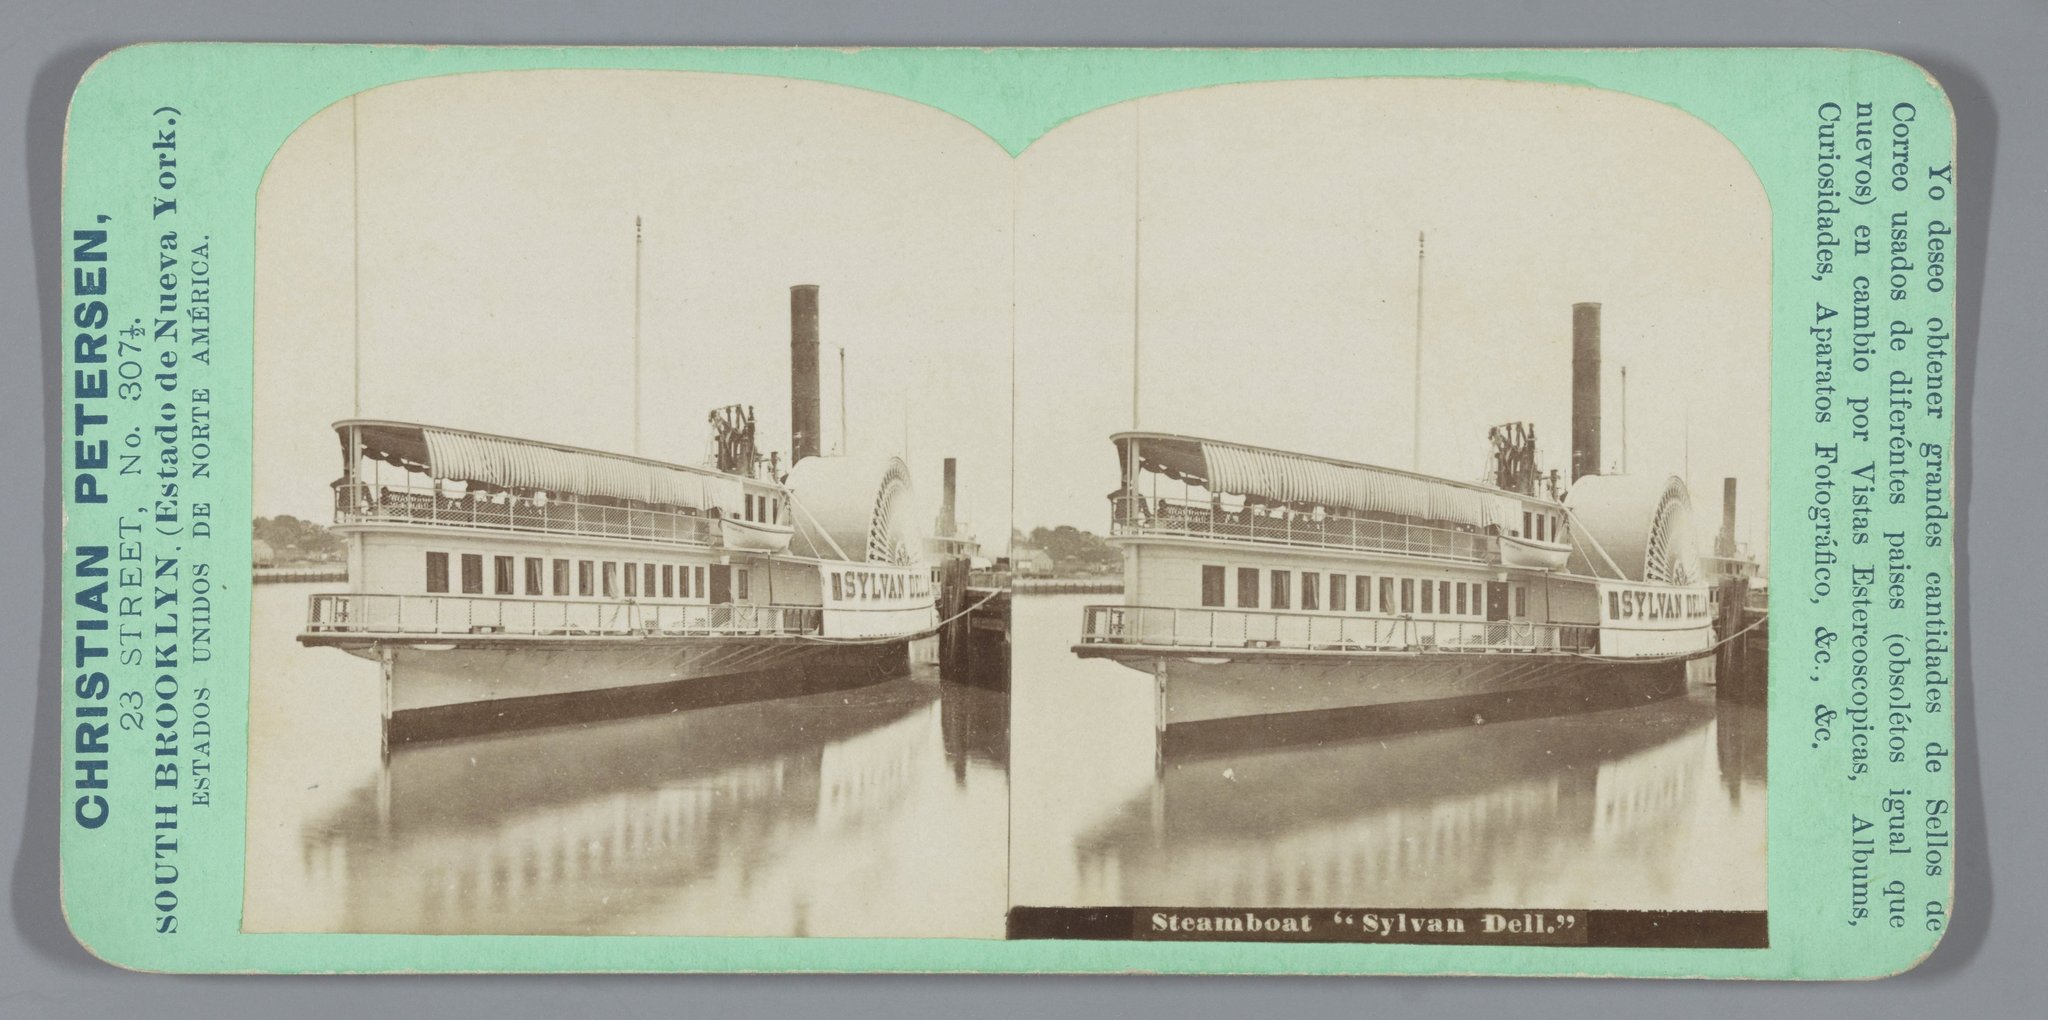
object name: stereograph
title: Steamboat "Sylvan Dell"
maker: christian petersen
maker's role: fotograaf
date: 1872-1890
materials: cardboard, paper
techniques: albumen print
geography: new york city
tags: ships (in general), new york (city)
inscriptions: inscription: ‘Yo deseo obtener millones de Sellos de Correo/ usados de differéntes paises (obsolétos igual que nuevos)/ en cambio por Vistas Estereoscopias, Albums, Curiosidades,/ Aparatos Fotográfico, Relojes de Música, &c.’